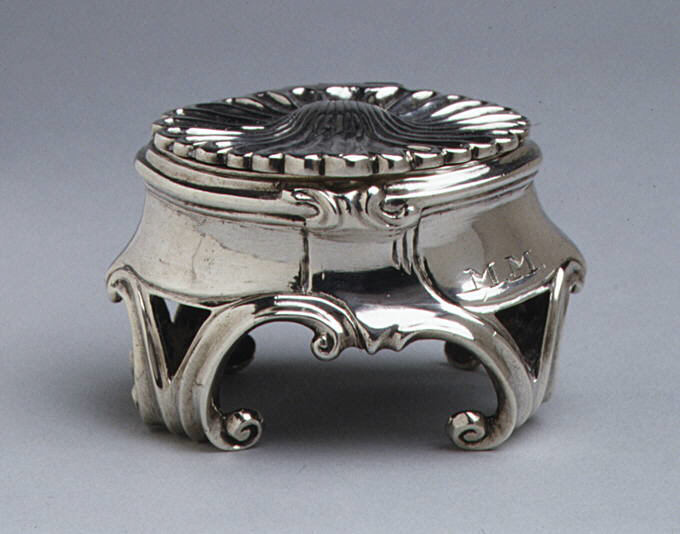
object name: salt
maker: r. eva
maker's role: maker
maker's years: 1700-1800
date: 1701-1800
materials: silver